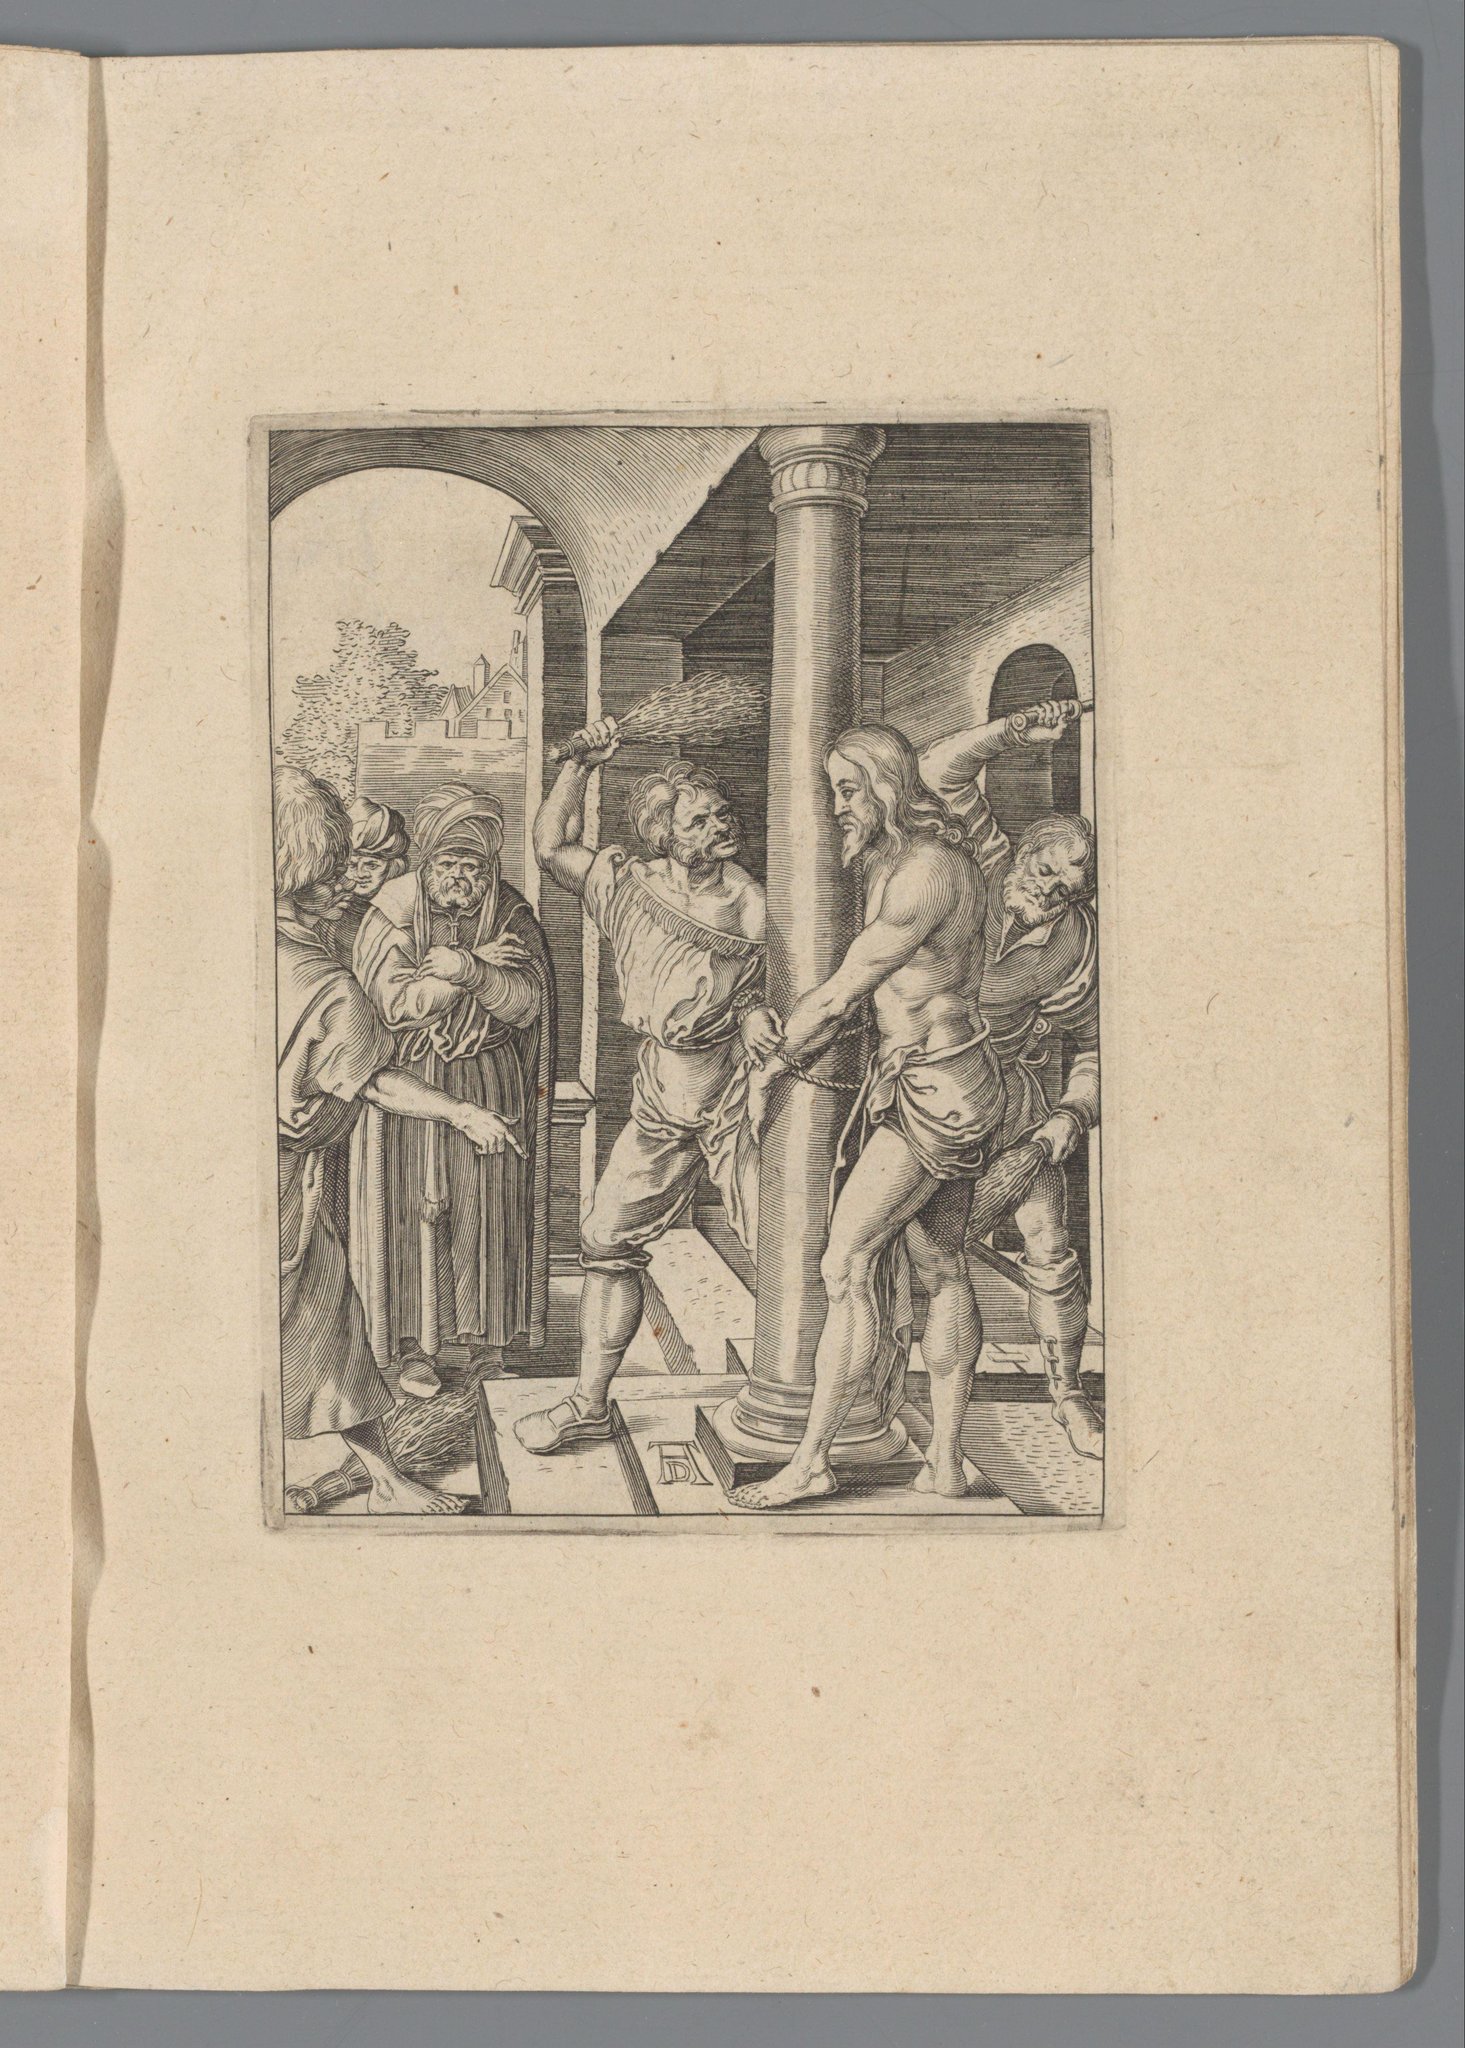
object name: print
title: Geseling van Christus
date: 1610-1620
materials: paper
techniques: engraving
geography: the hague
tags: flagellation by soldiers, christ usually tied to a column (matthew 27:26; mark 15:15; john 19:1)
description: Christus wordt, gebonden aan een zuil, gegeseld door mannen met takkenbossen. Prent maakt deel uit van een album.